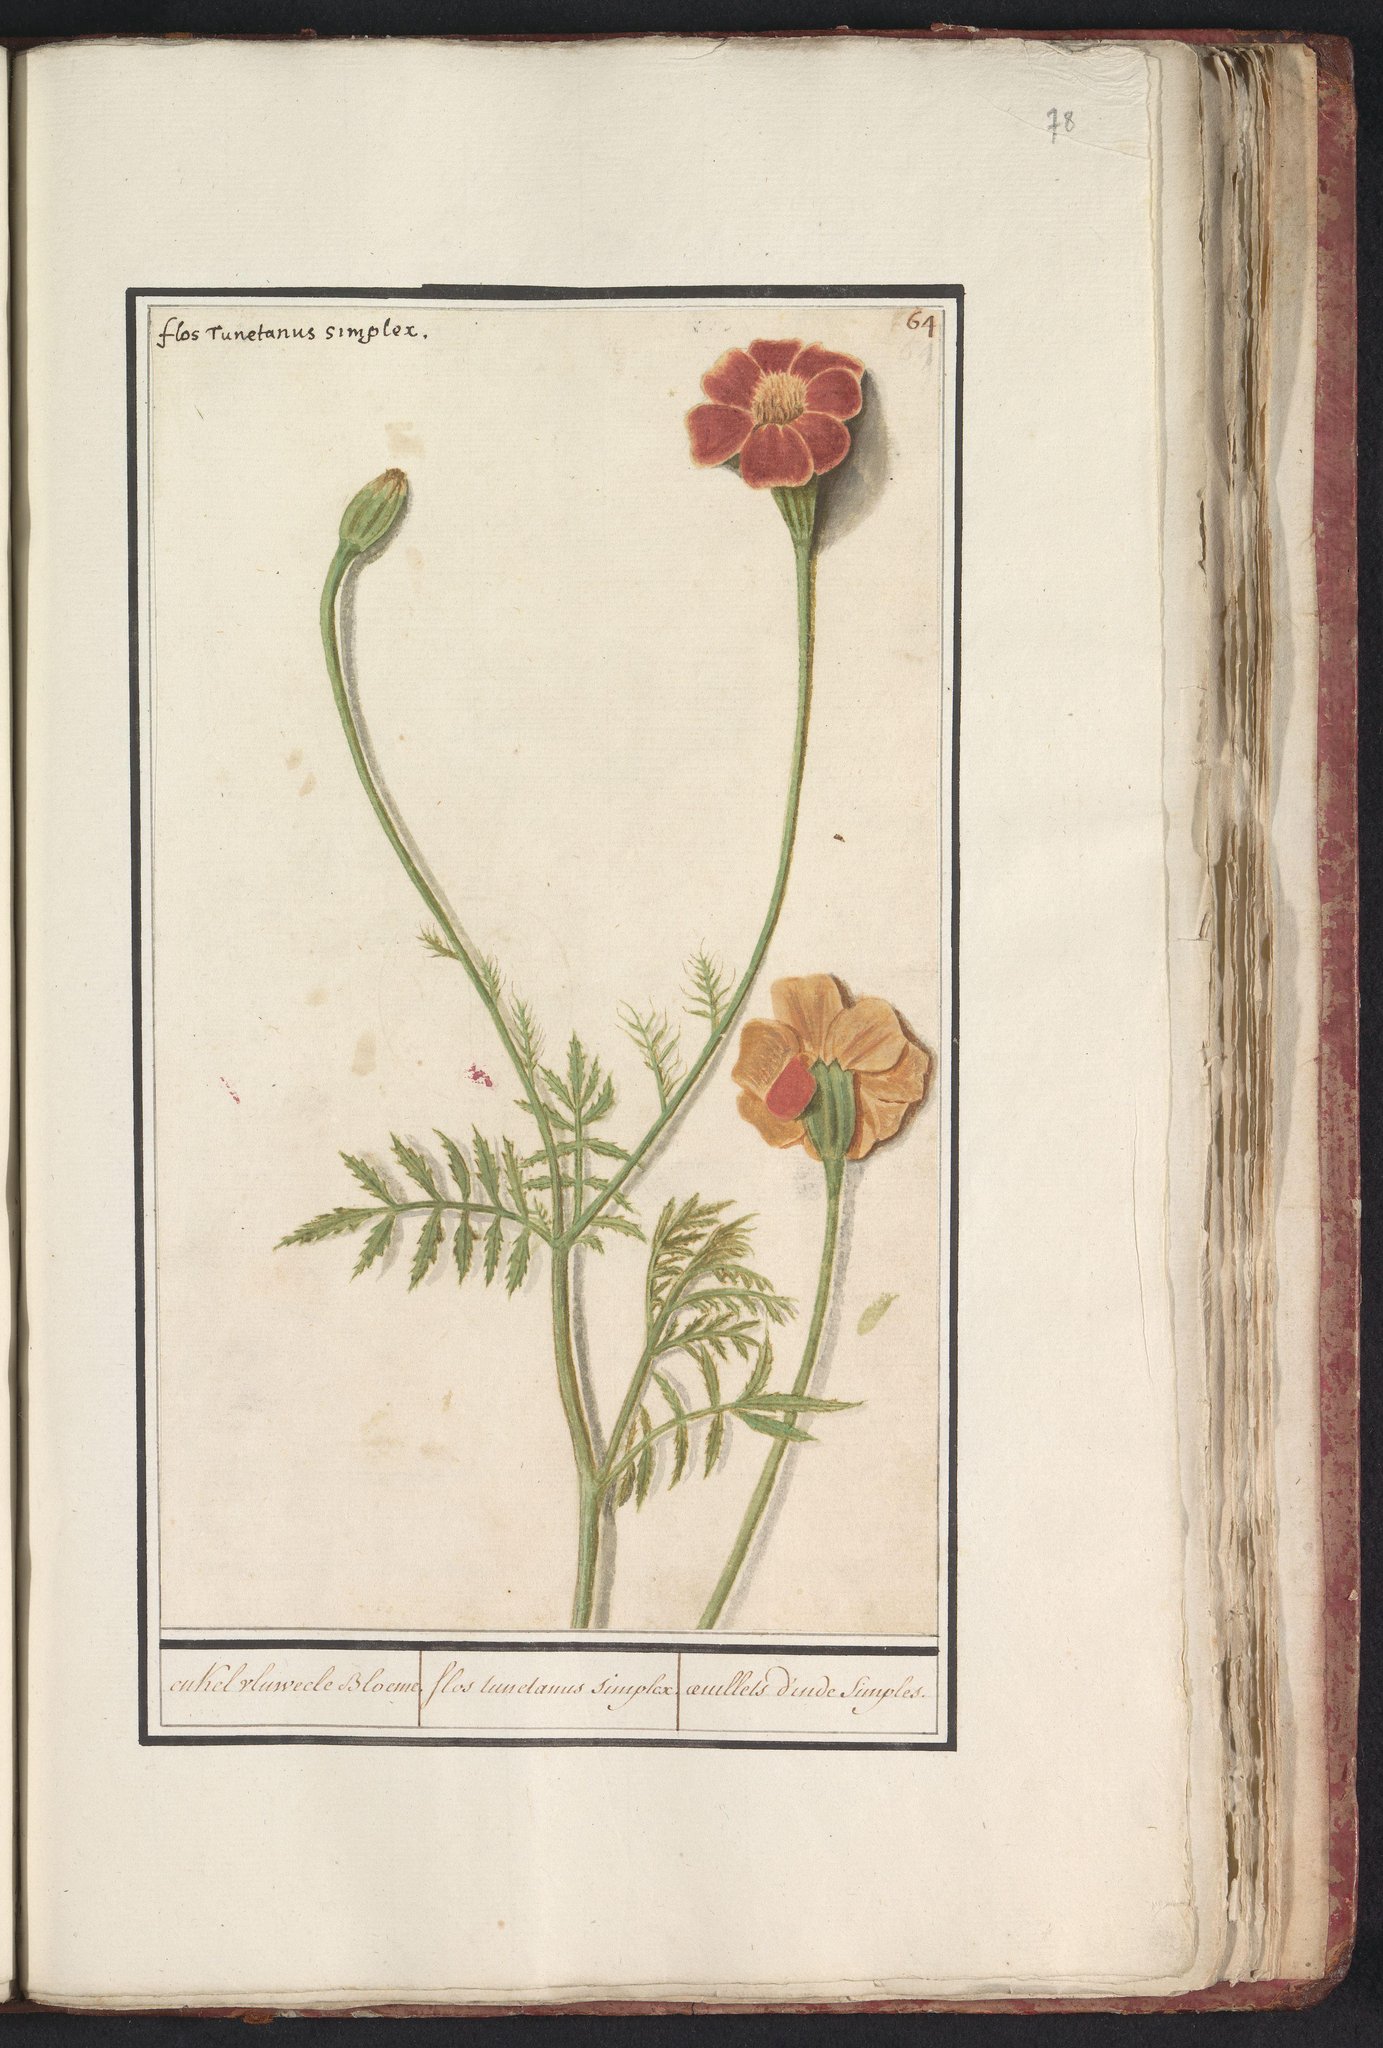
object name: drawing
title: Afrikaantje (Tagetes)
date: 1596-1610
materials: chalk, paint, ink, paper, watercolor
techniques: brush, pen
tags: flowers: marigold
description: Donkeroranje afrikaantjes. Genummerd rechtsboven: 64. Linksboven de Latijnse naam. Onderdeel van het eerste album met tekeningen van bloemen en planten. Achtste van twaalf albums met tekeningen van dieren, vogels en planten bekend rond 1600, gemaakt in opdracht van keizer Rudolf II. Met toelichting in Nederlands, Latijn en Frans.